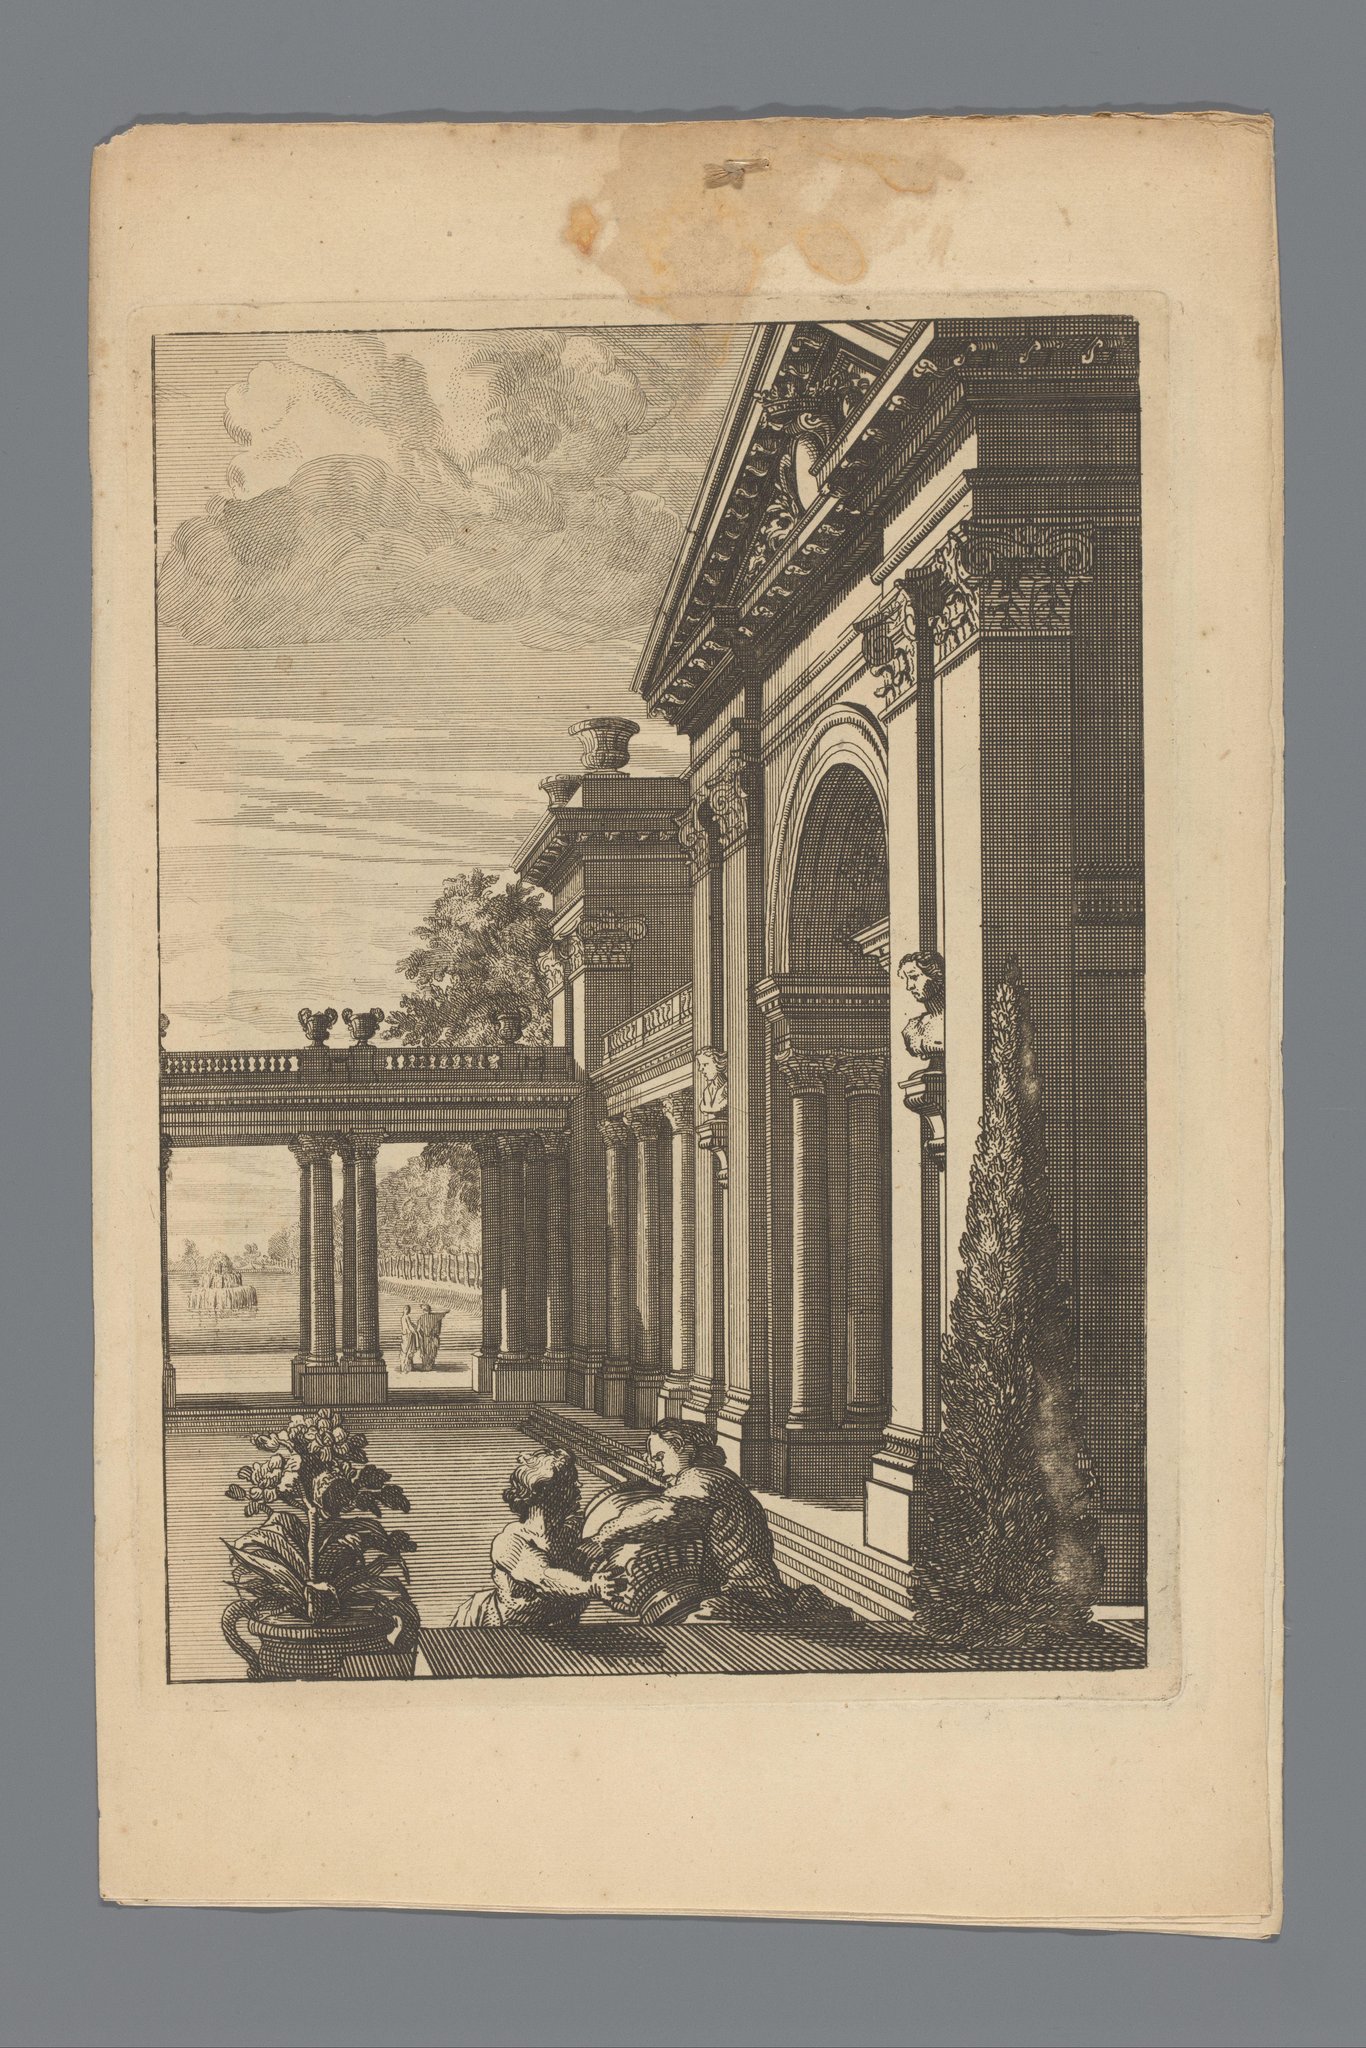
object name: ornament print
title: Troisieme Liure de Perspectives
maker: Anonymous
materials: paper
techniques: etching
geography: netherlands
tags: vestibule, hall, façade (of house or building)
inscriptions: collector's mark: Lugt 2233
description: Façade van een vestibule met Korinthische zuilen. Links een colonnade met doorkijk richting een fontein. In de voorgrond tillen twee mannen een vaas van een voetstuk.